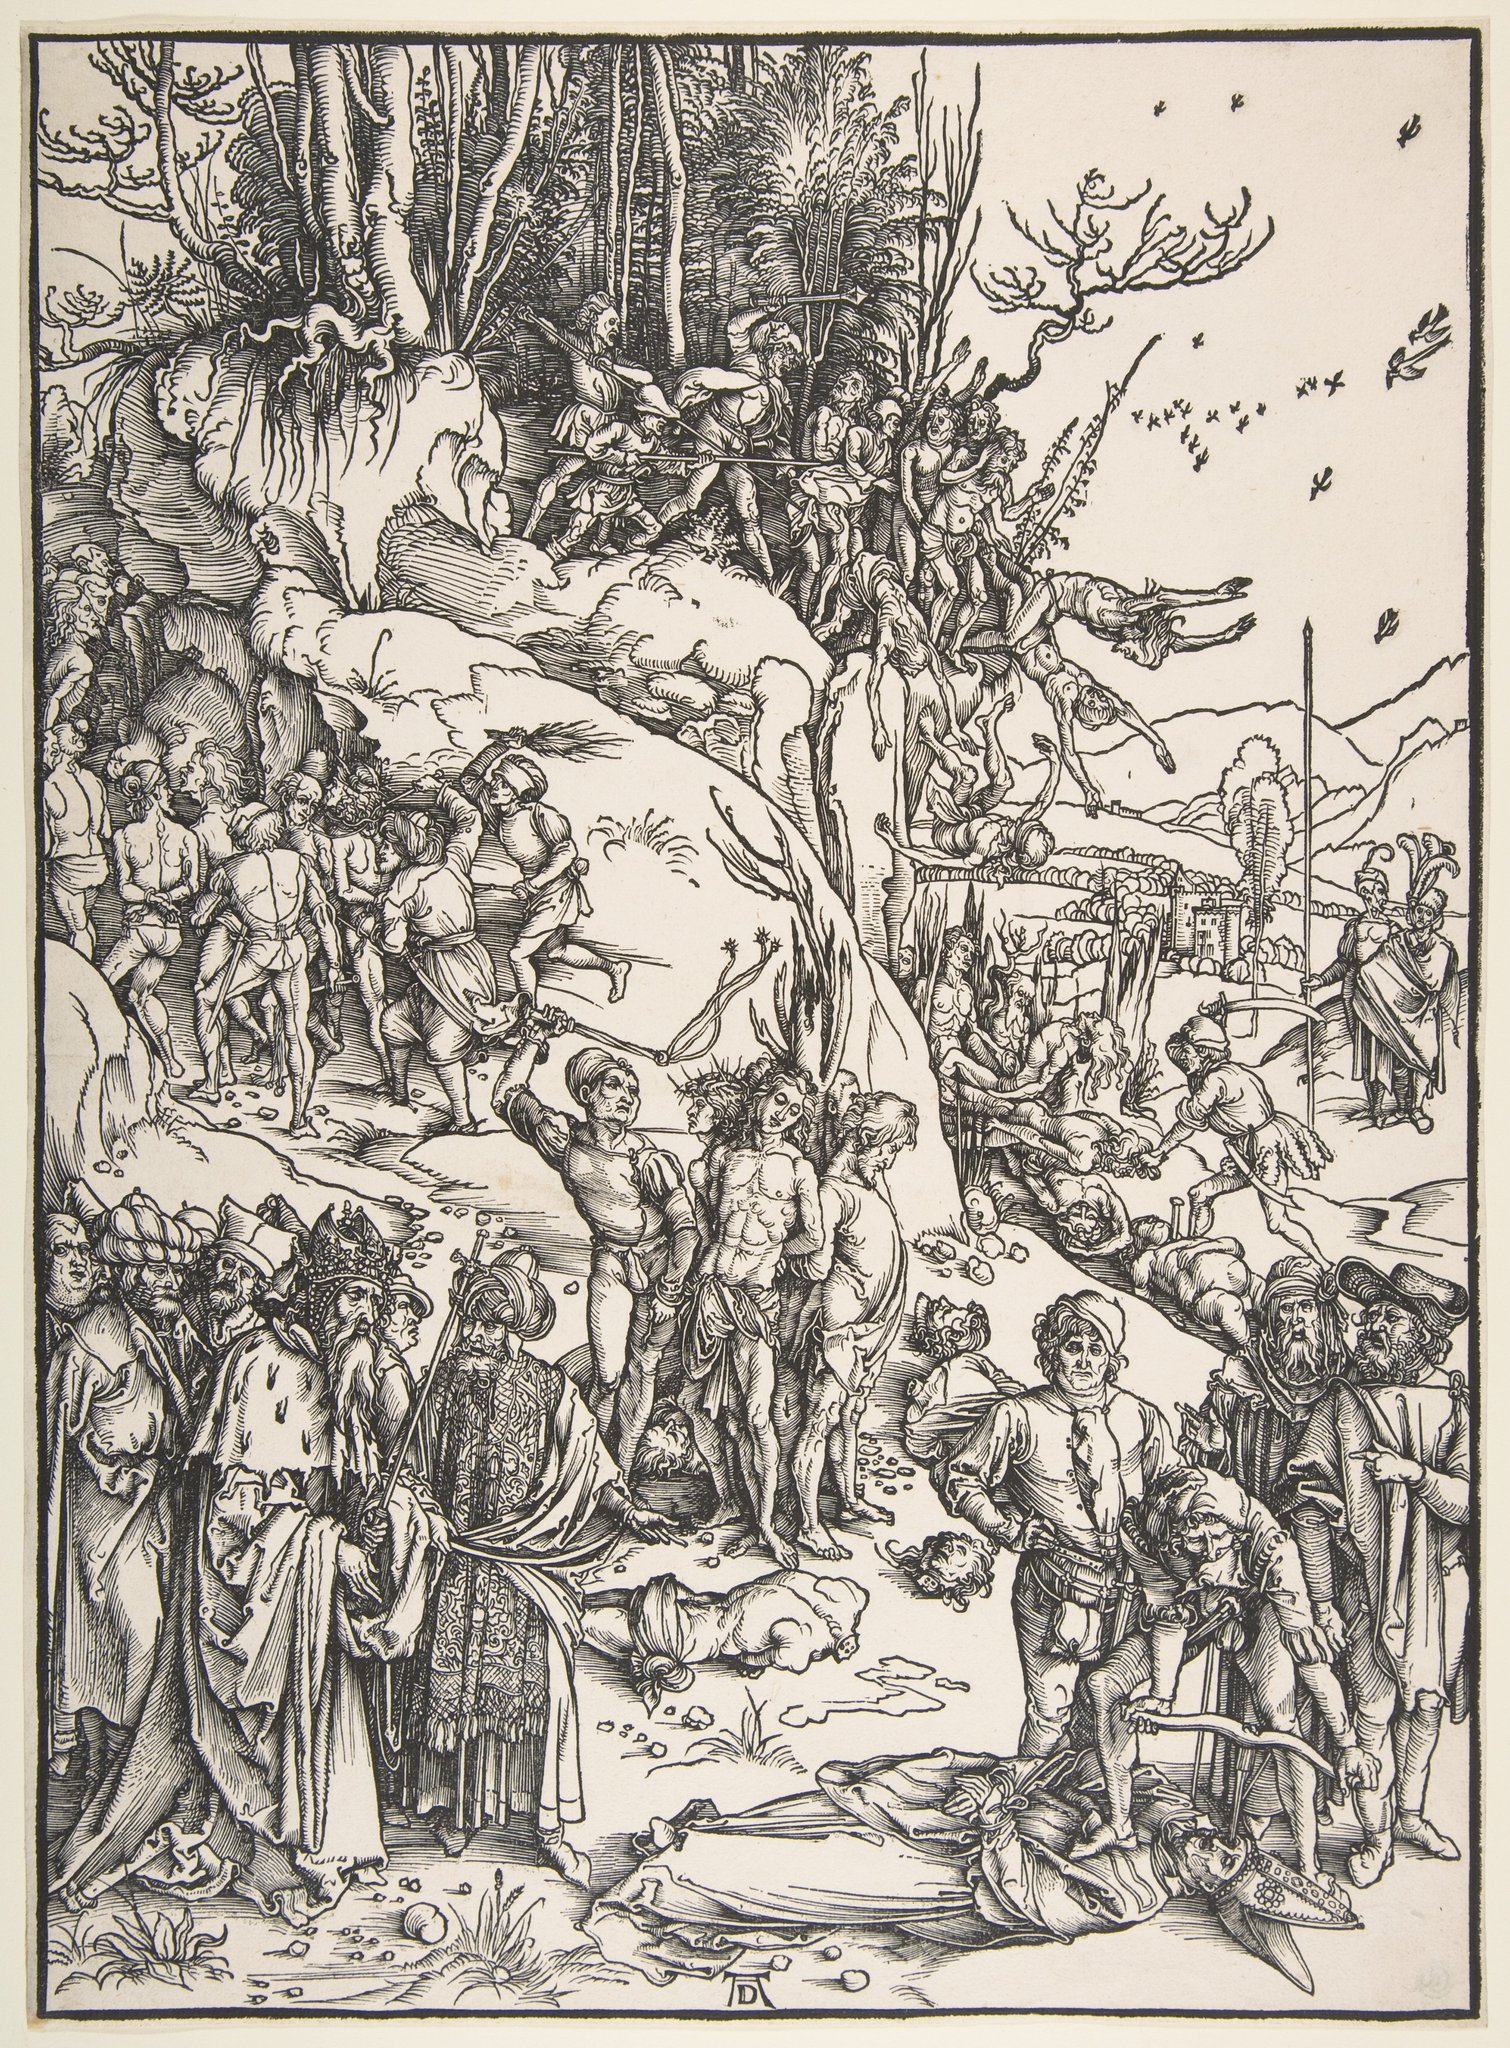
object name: print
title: Martyrdom of the Ten Thousand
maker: albrecht dürer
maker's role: artist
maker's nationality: german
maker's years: 1471-1528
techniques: woodcut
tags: men,death